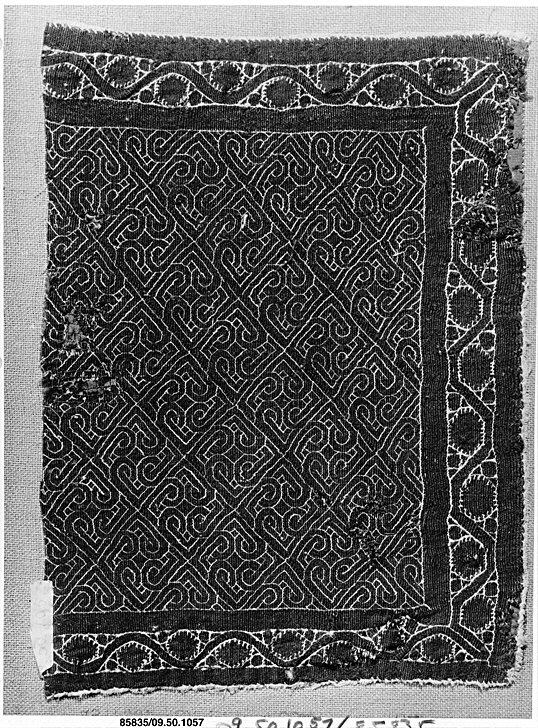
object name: textile fragment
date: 301-500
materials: linen, wool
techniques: weave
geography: egypt